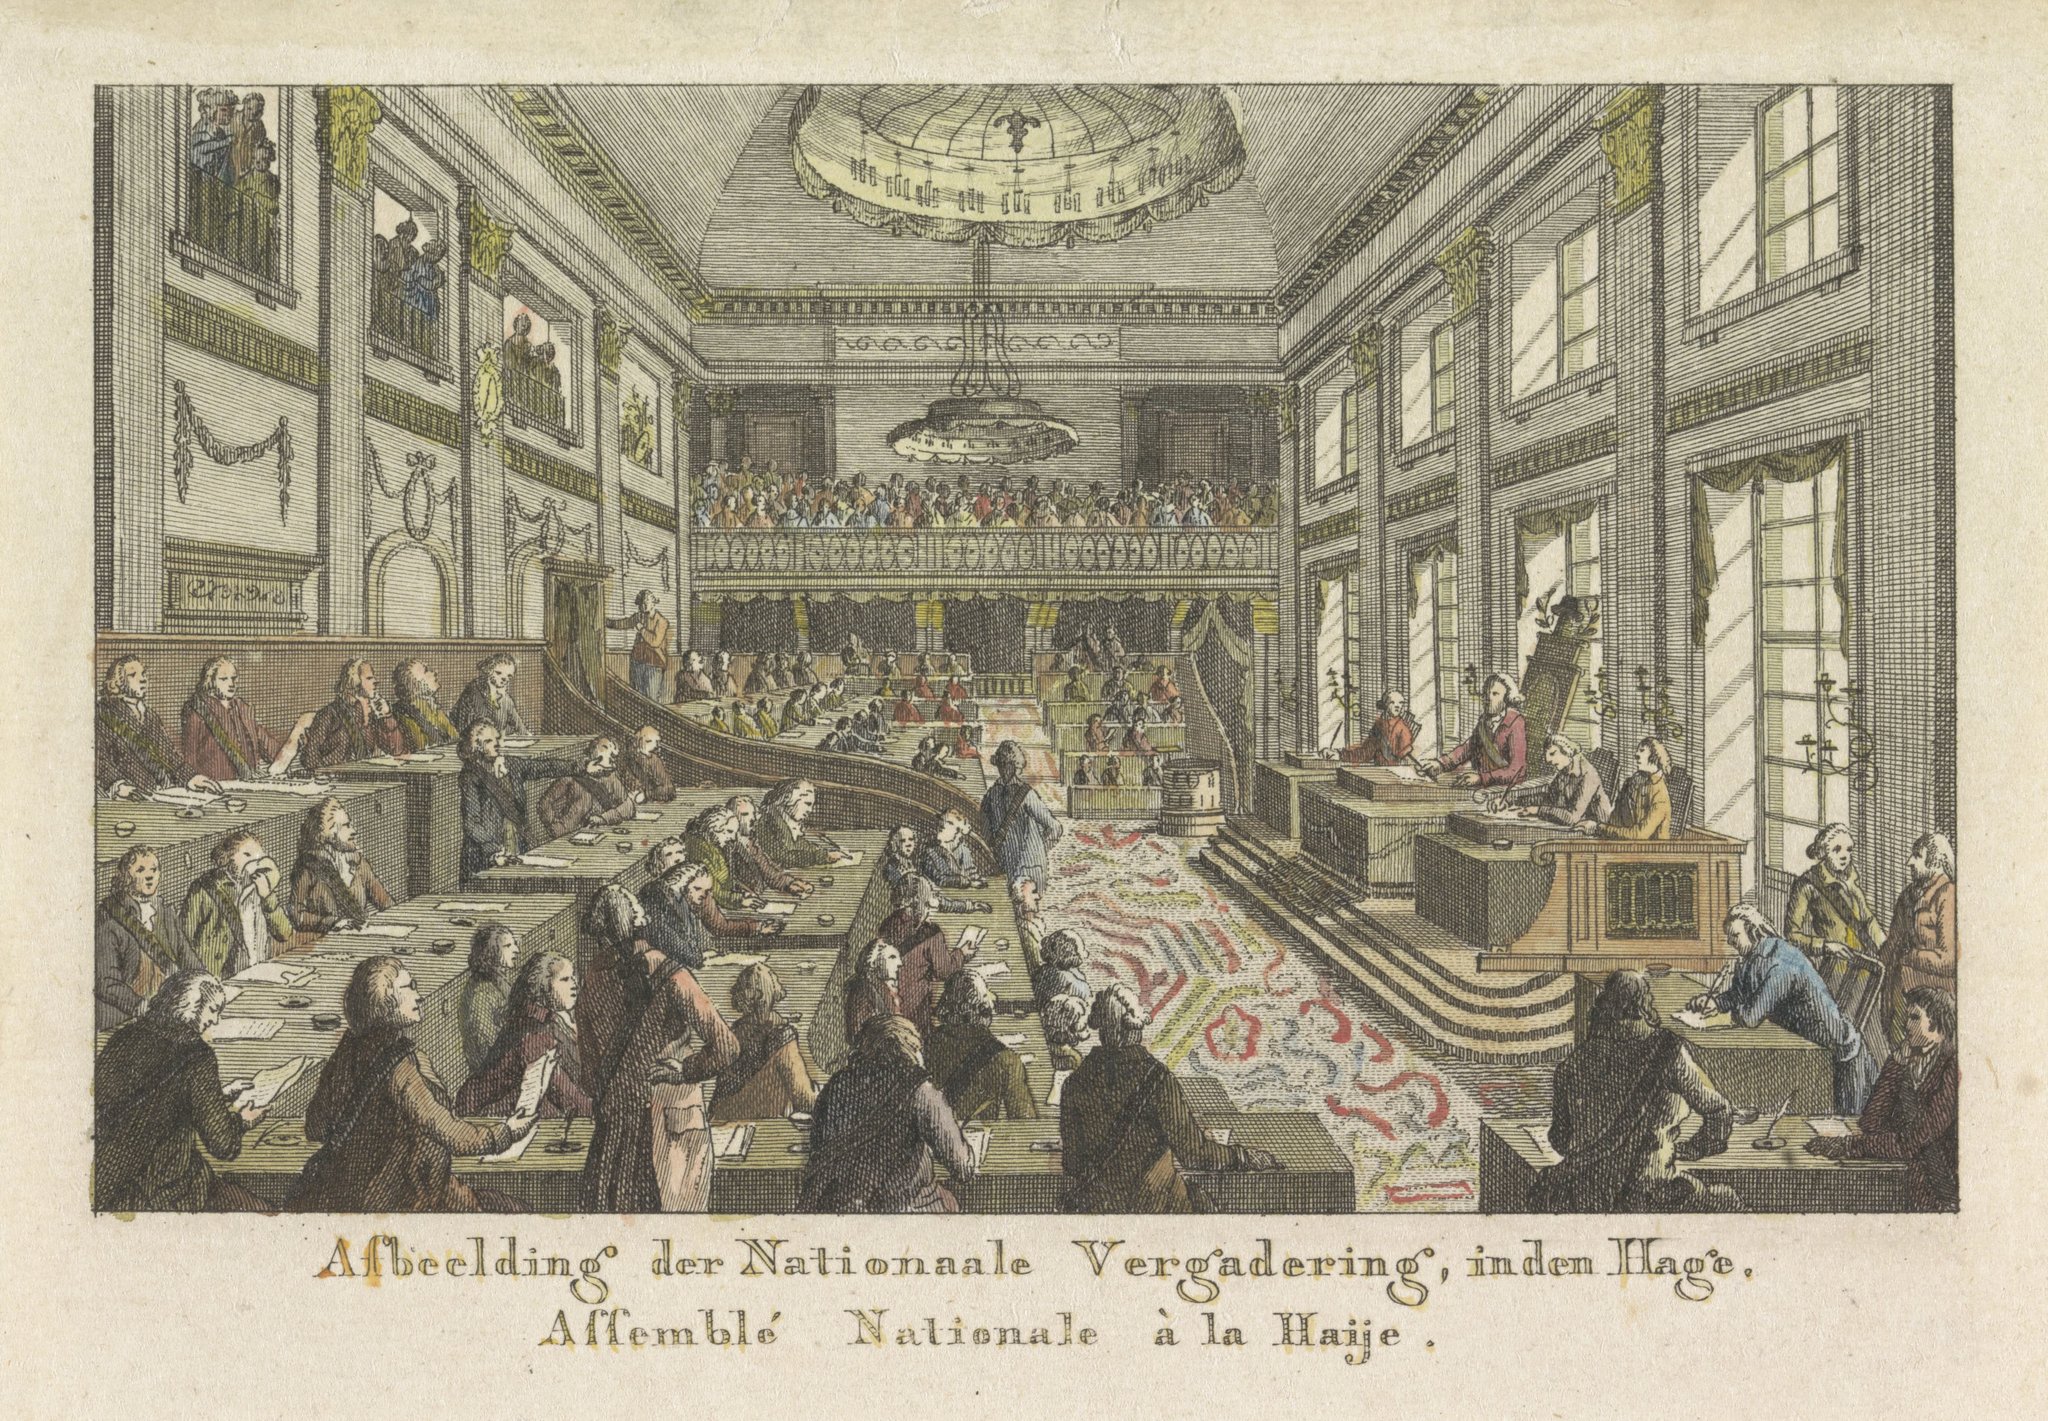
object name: history print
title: Eerste Nationale Vergadering in Den Haag, 1796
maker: Anonymous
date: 1796-1810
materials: paper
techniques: engraving, etching, hand coloring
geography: netherlands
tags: revolutionary government, lower house, parliament, chamber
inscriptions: collector's mark: Lugt 2228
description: Zitting van de Eerste Nationale Vergadering in Den Haag, van 1 maart 1796 tot 31 augustus 1797. Gezicht in de vergaderzaal (voormalige danszaal van het Stadhouderlijke Paleis) met de leden, allen met lint als representant. Op de achtergrond de volle publieke tribune.